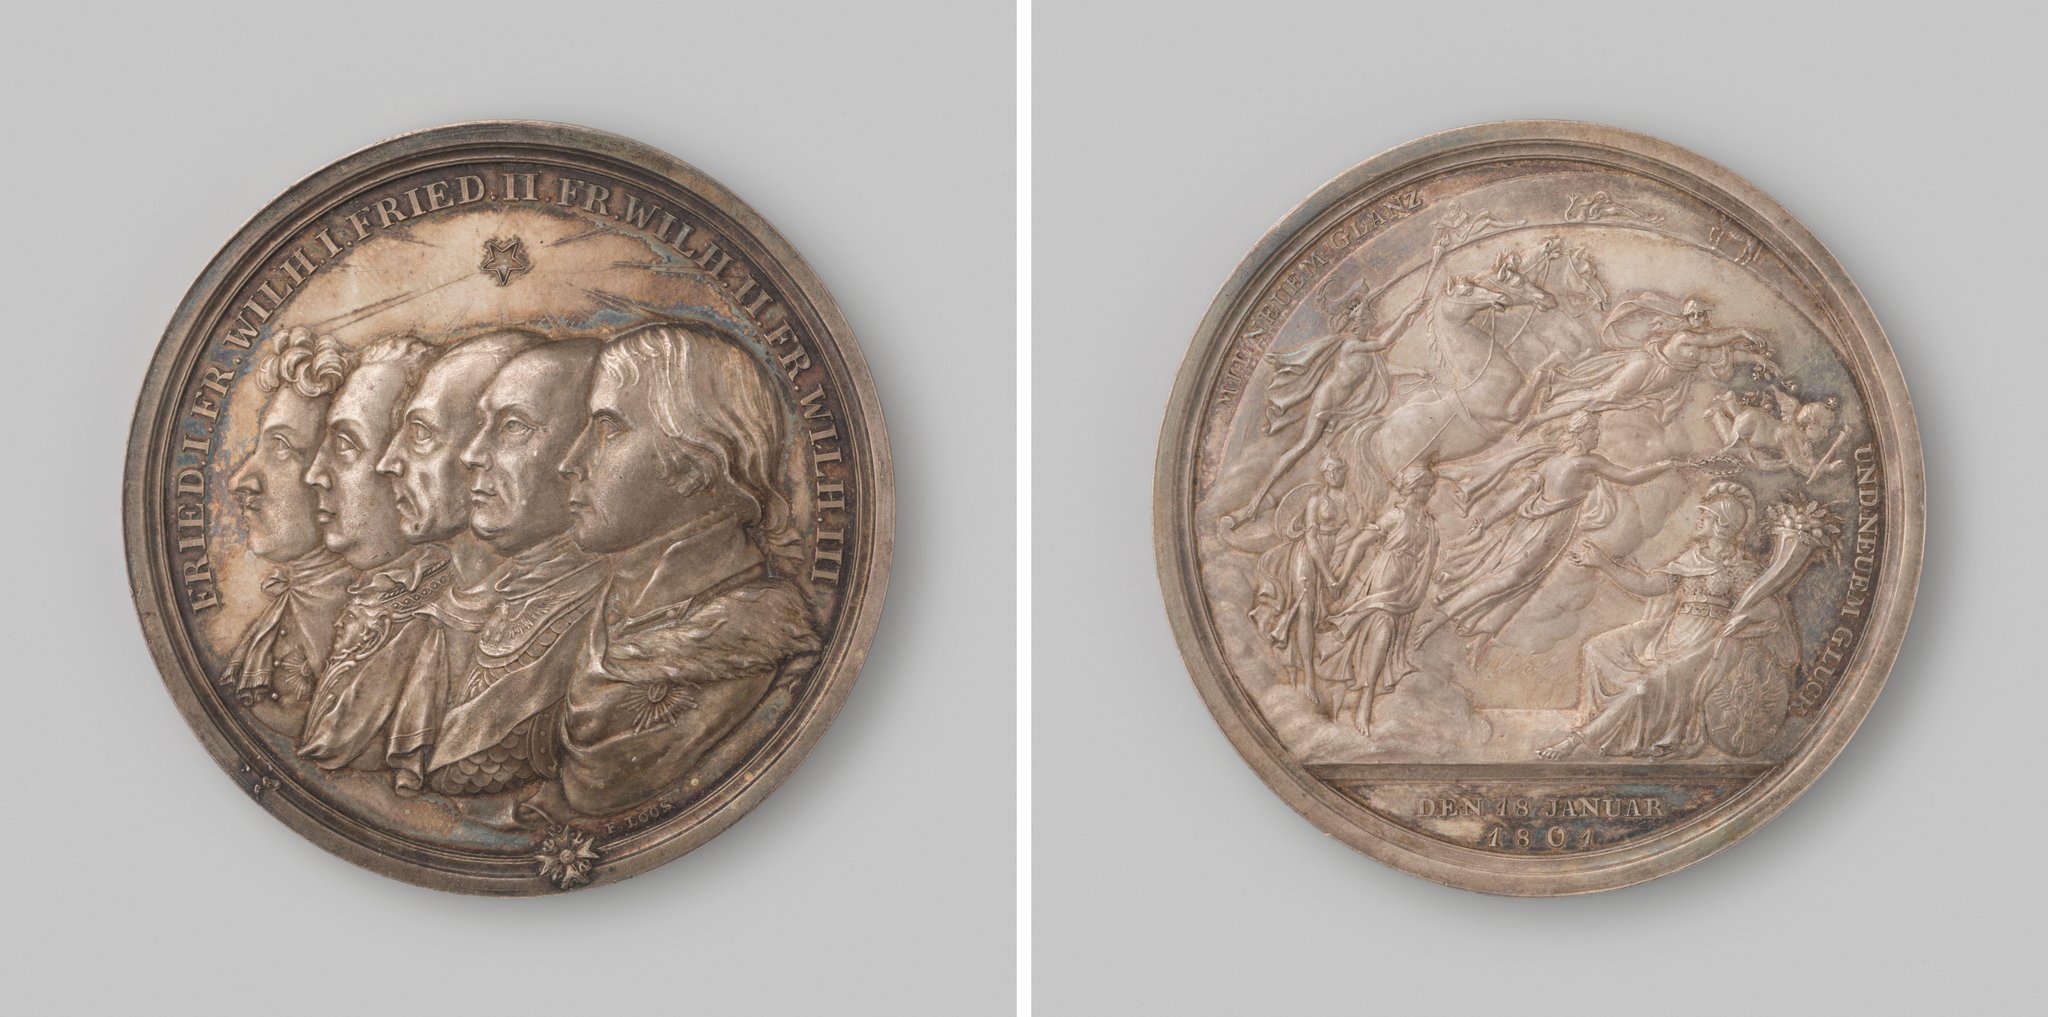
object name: history medal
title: Honderdjarig bestaan van het Koninkrijk Pruisen 1801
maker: daniel friedrich loos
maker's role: medailleur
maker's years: 1735-1819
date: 1801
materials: silver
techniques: striking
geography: berlin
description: Zilveren penning, op de voorzijde de geconjugeerde borstbeelden van de vijf koningen van Pruissen naar links onder een stralende ster, met omschrift, op de keerzijde Pruisen als zittende vrouw naast Apollo's zonnewagen die langs de dierenriem stormt, met omschrift en afsnedetekst.